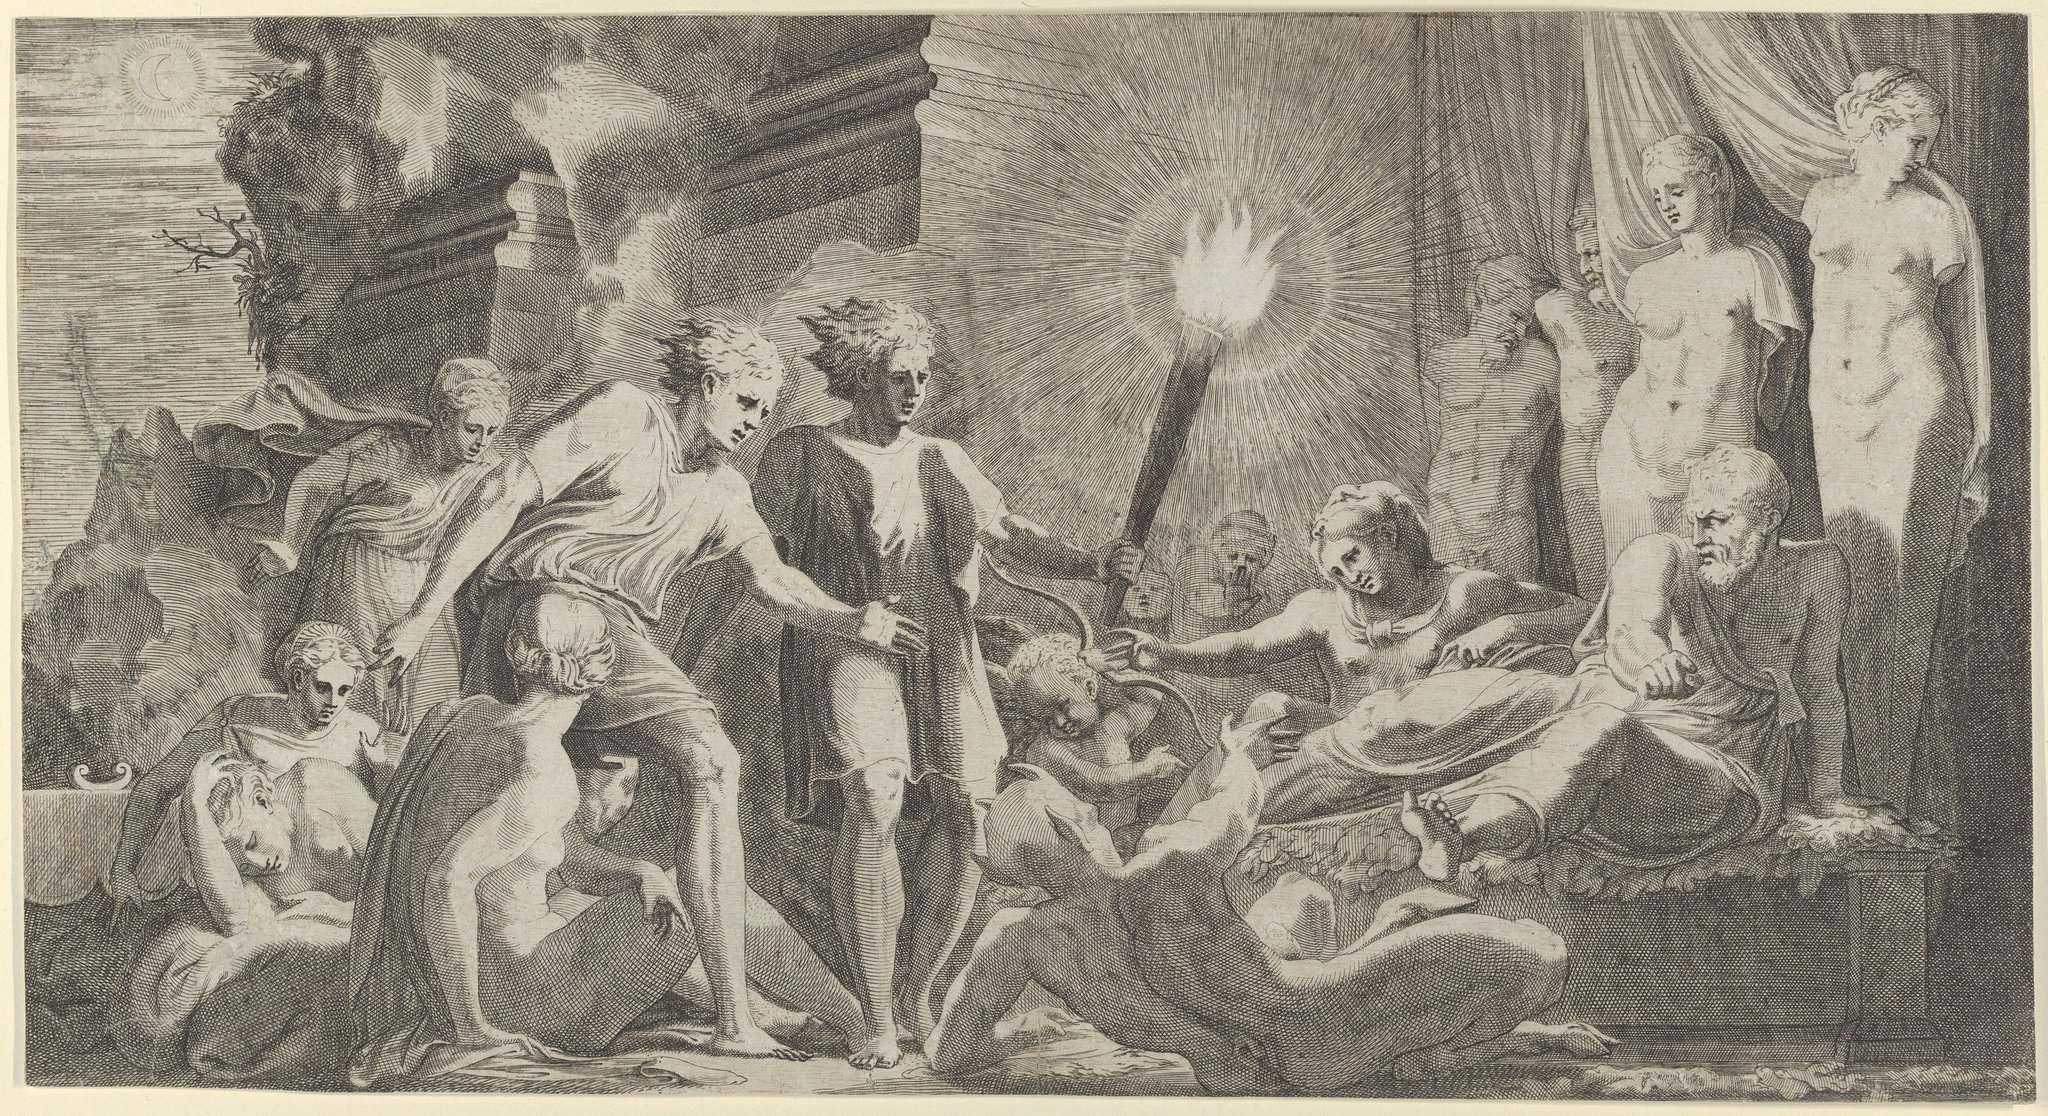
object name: print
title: Hercules surprising Fanus who mistook him for Omphale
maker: léon davent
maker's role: artist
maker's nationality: french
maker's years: 1540-1556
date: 1540-1556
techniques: engraving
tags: infants,male nudes,female nudes,hercules